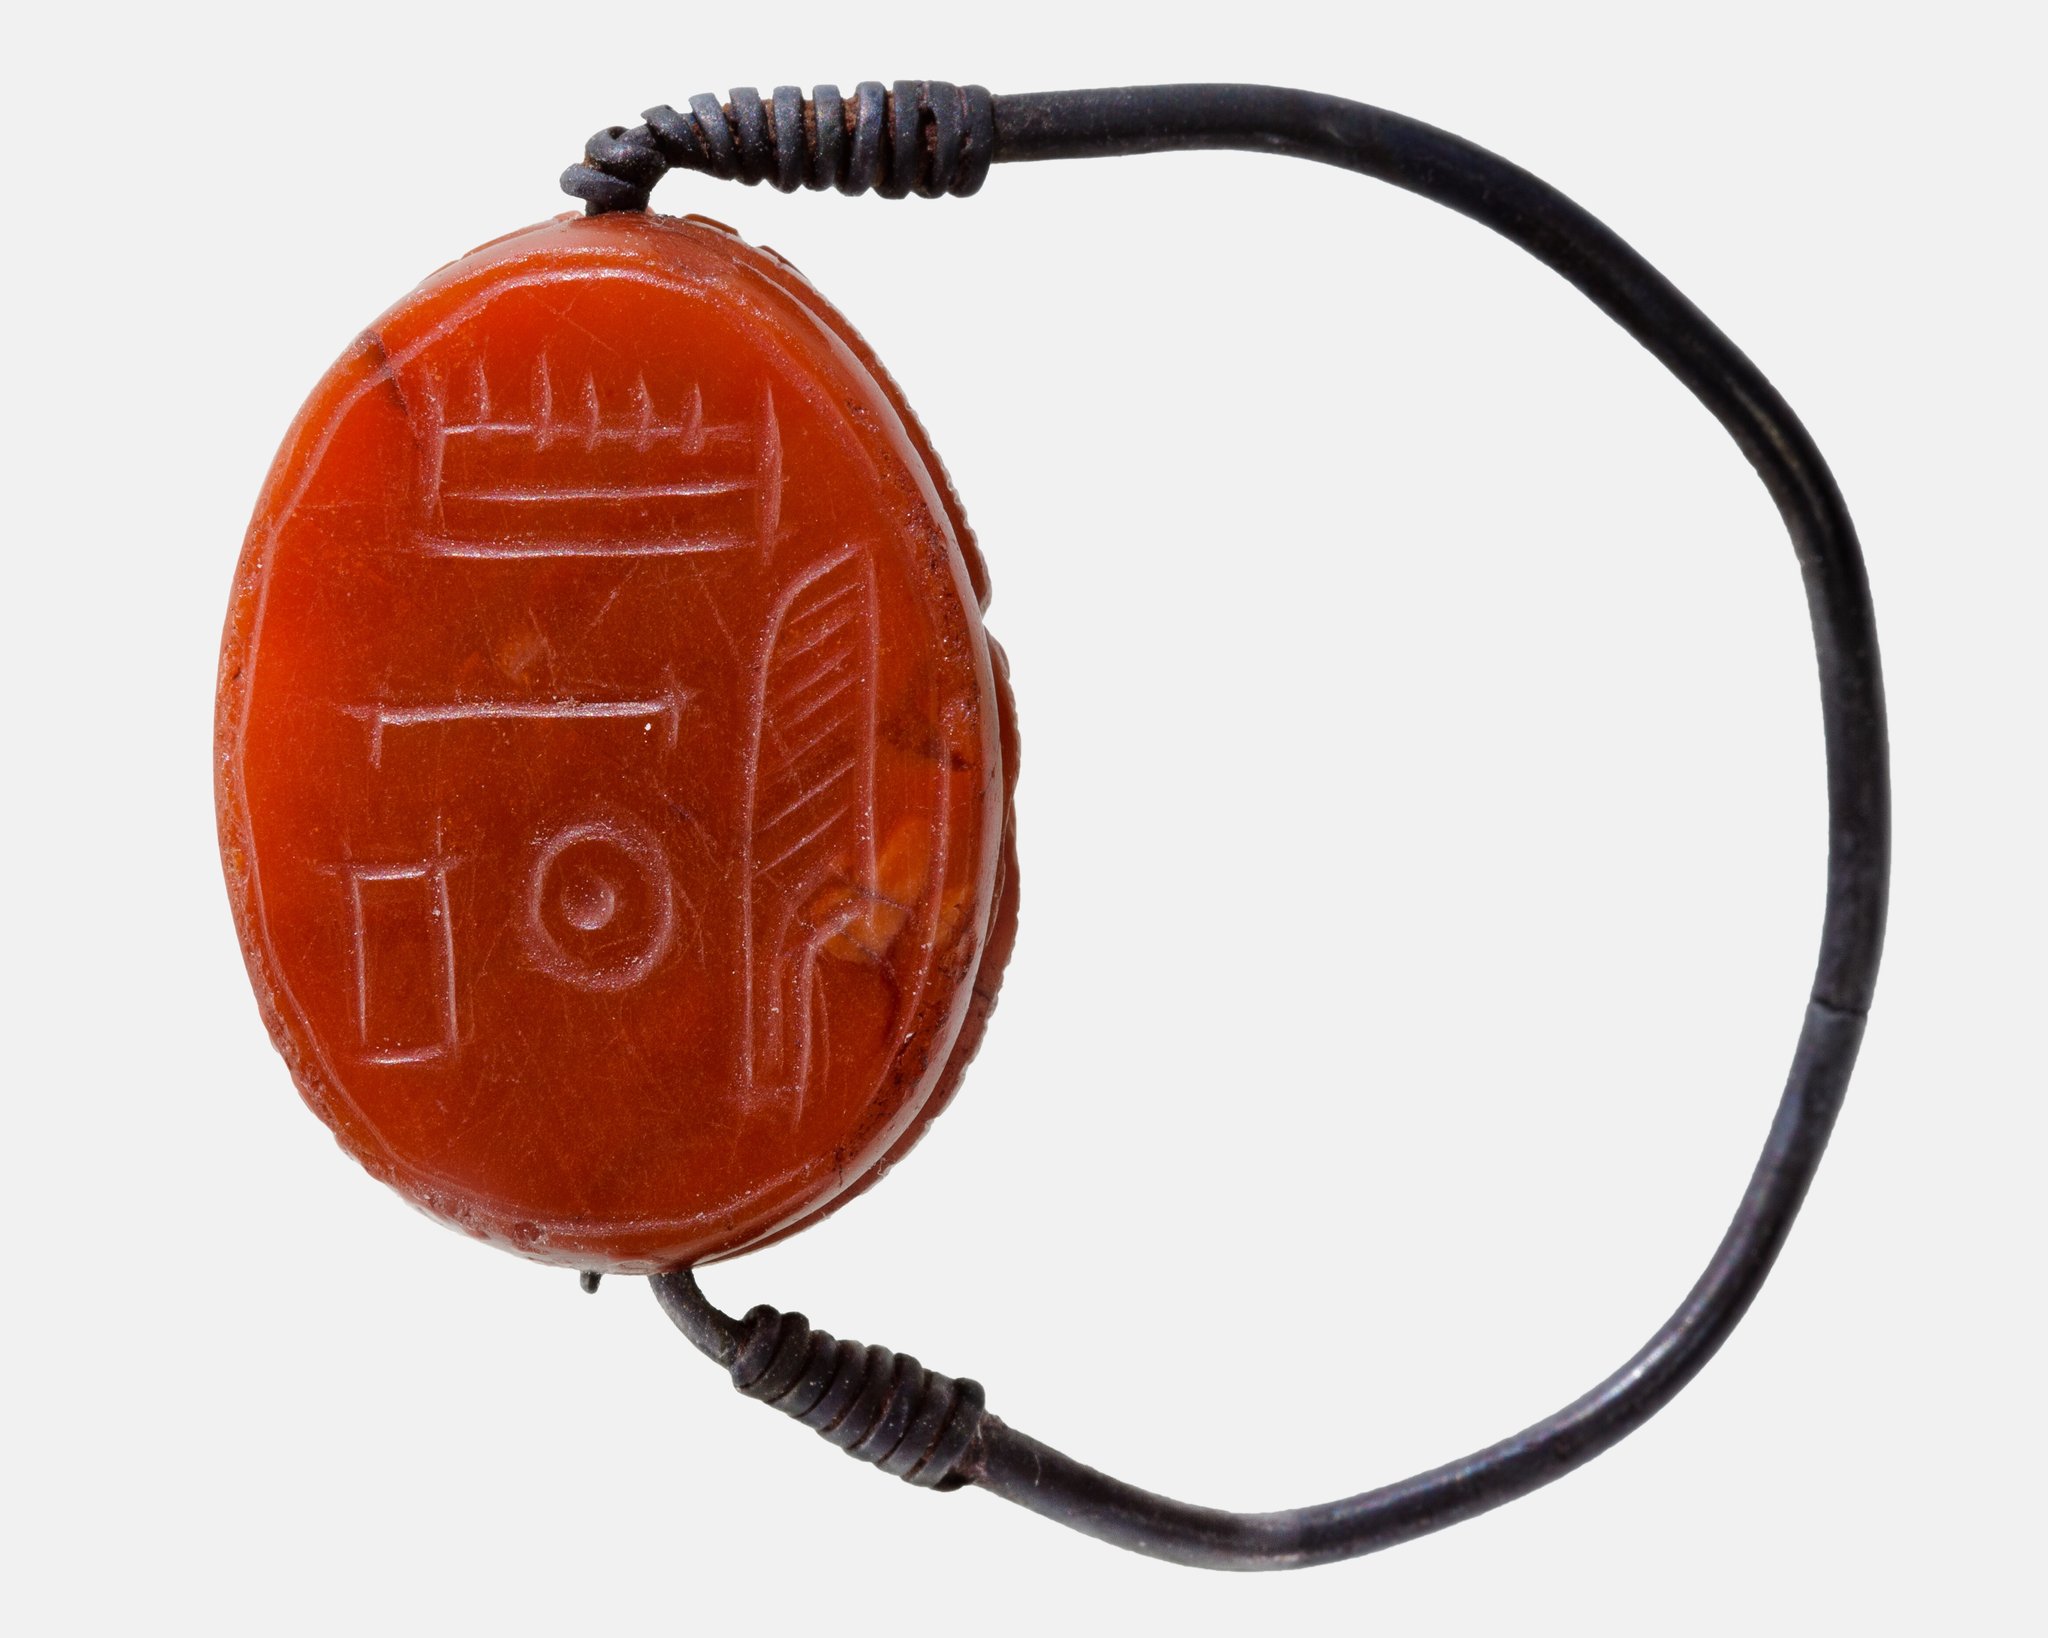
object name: ring with scarab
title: Scarab Finger Ring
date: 1479-1458 BCE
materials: jasper, silver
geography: egypt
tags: scarabs